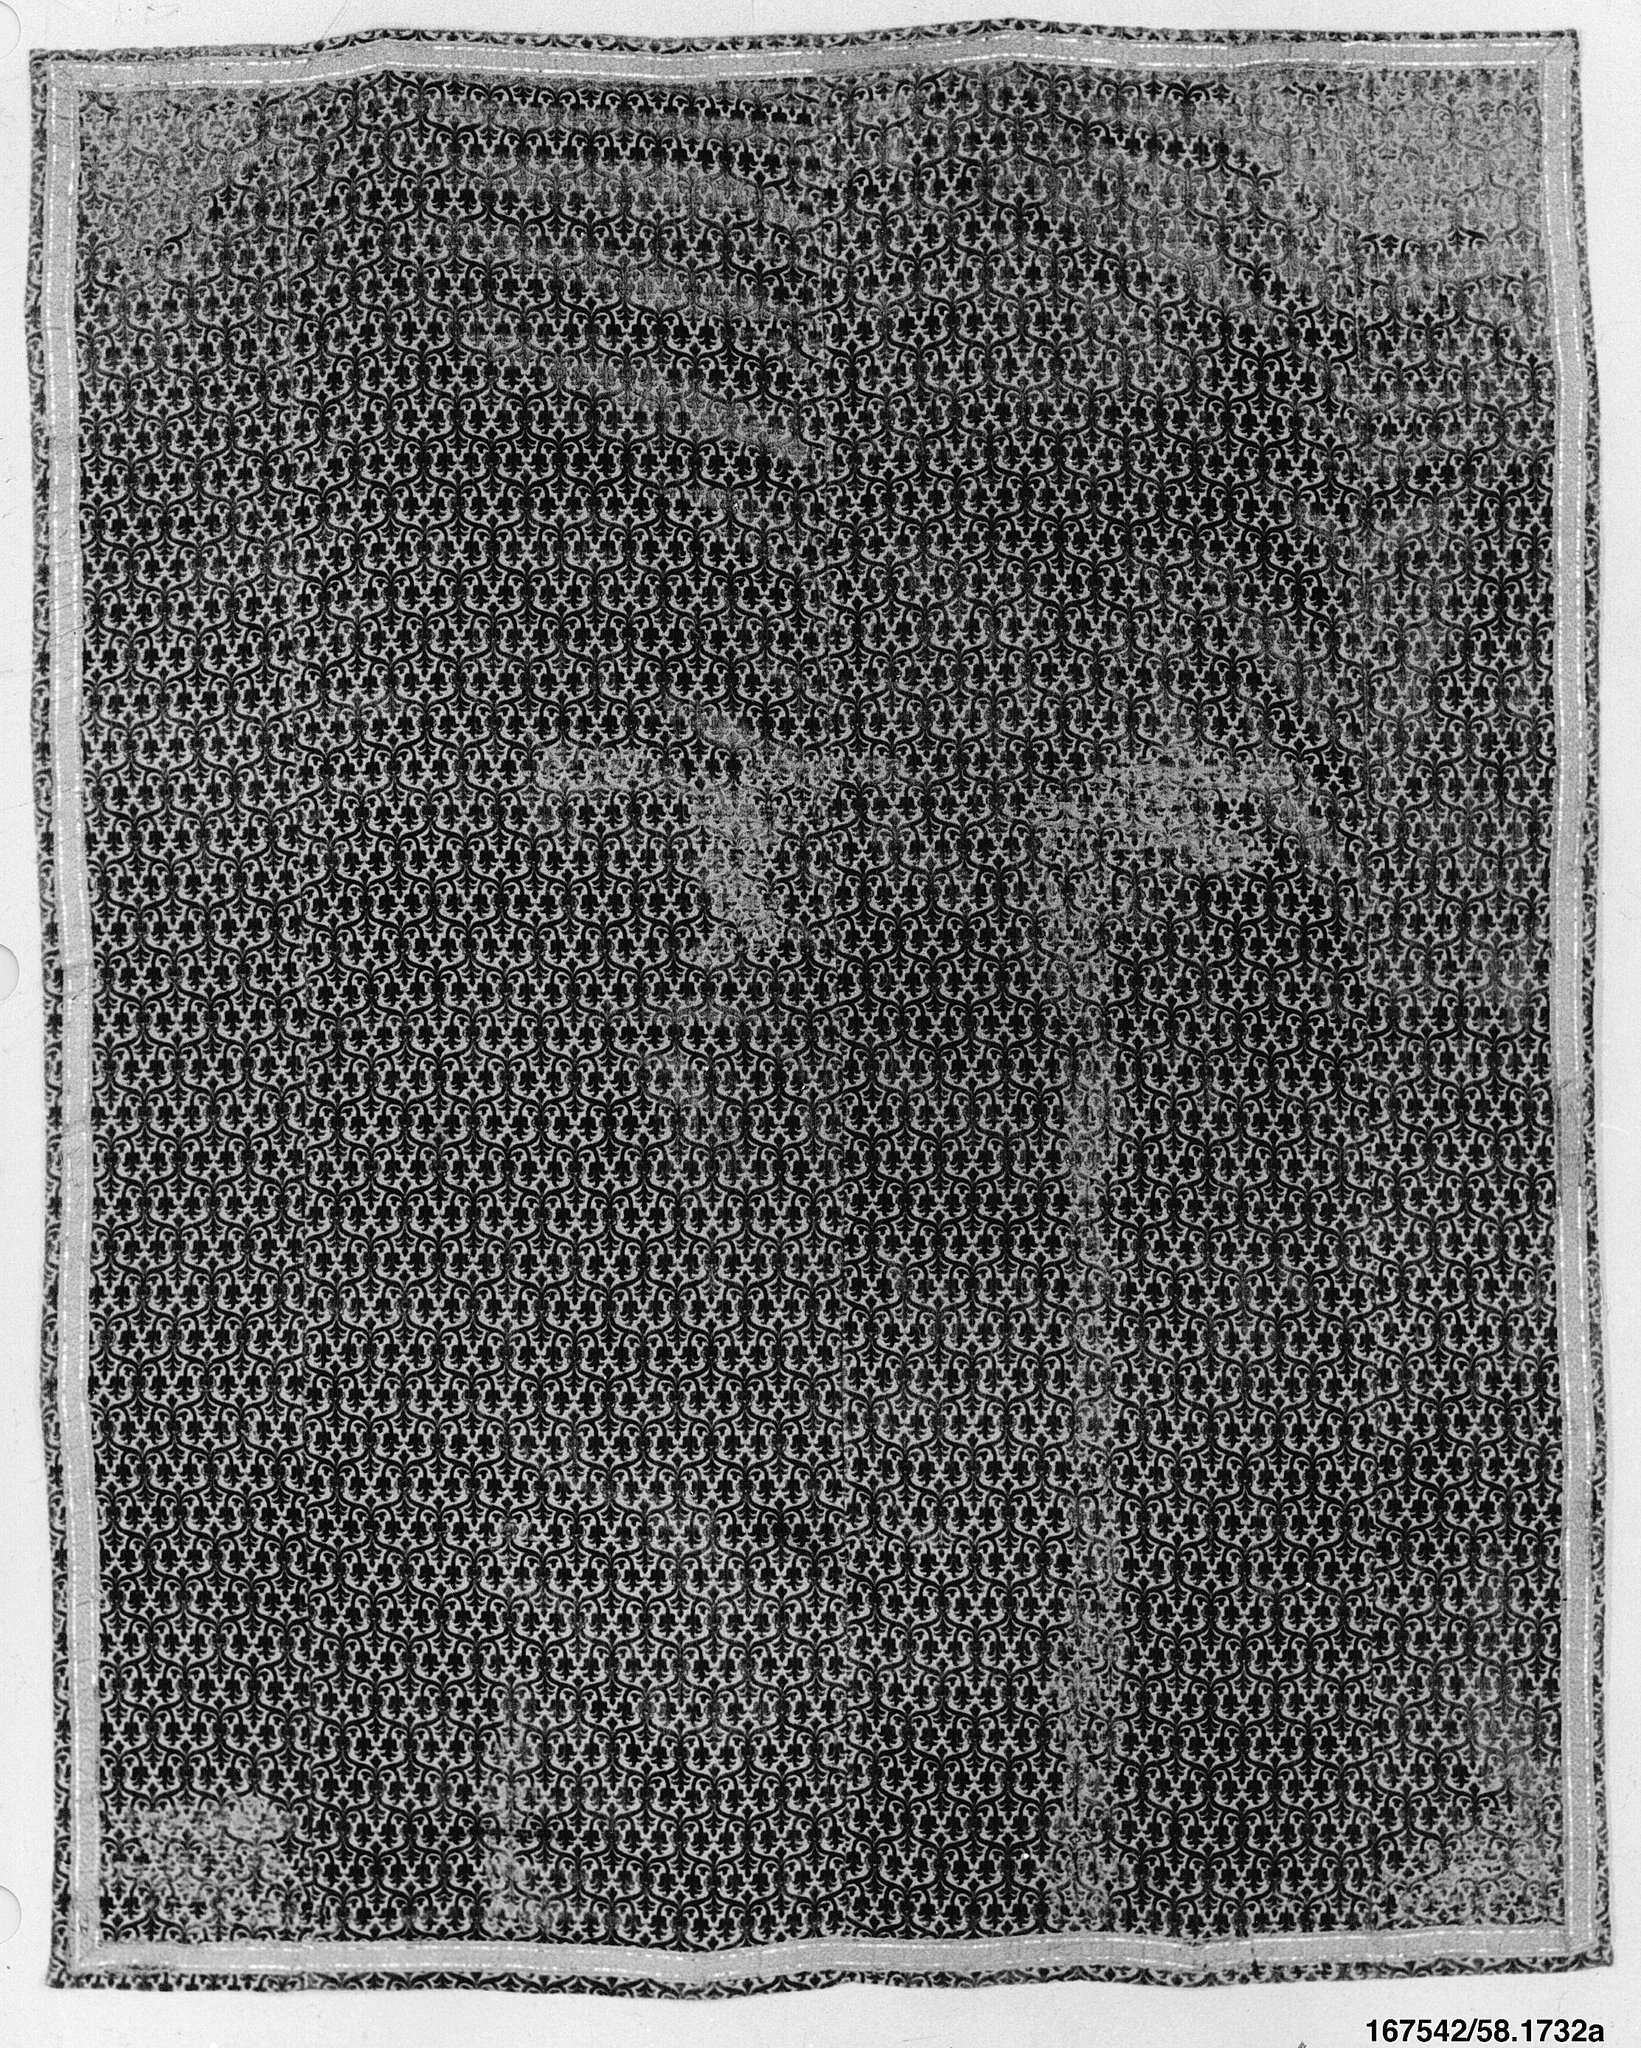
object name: piece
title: Pieces (2)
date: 1801-1900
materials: silk